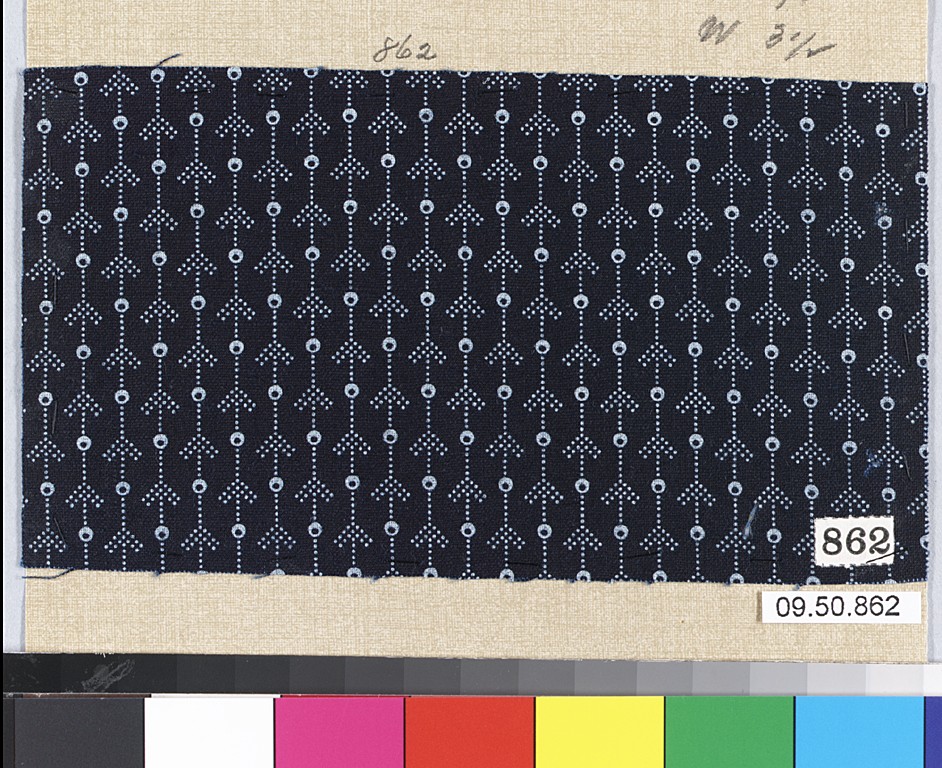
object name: piece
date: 1801-1900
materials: cotton